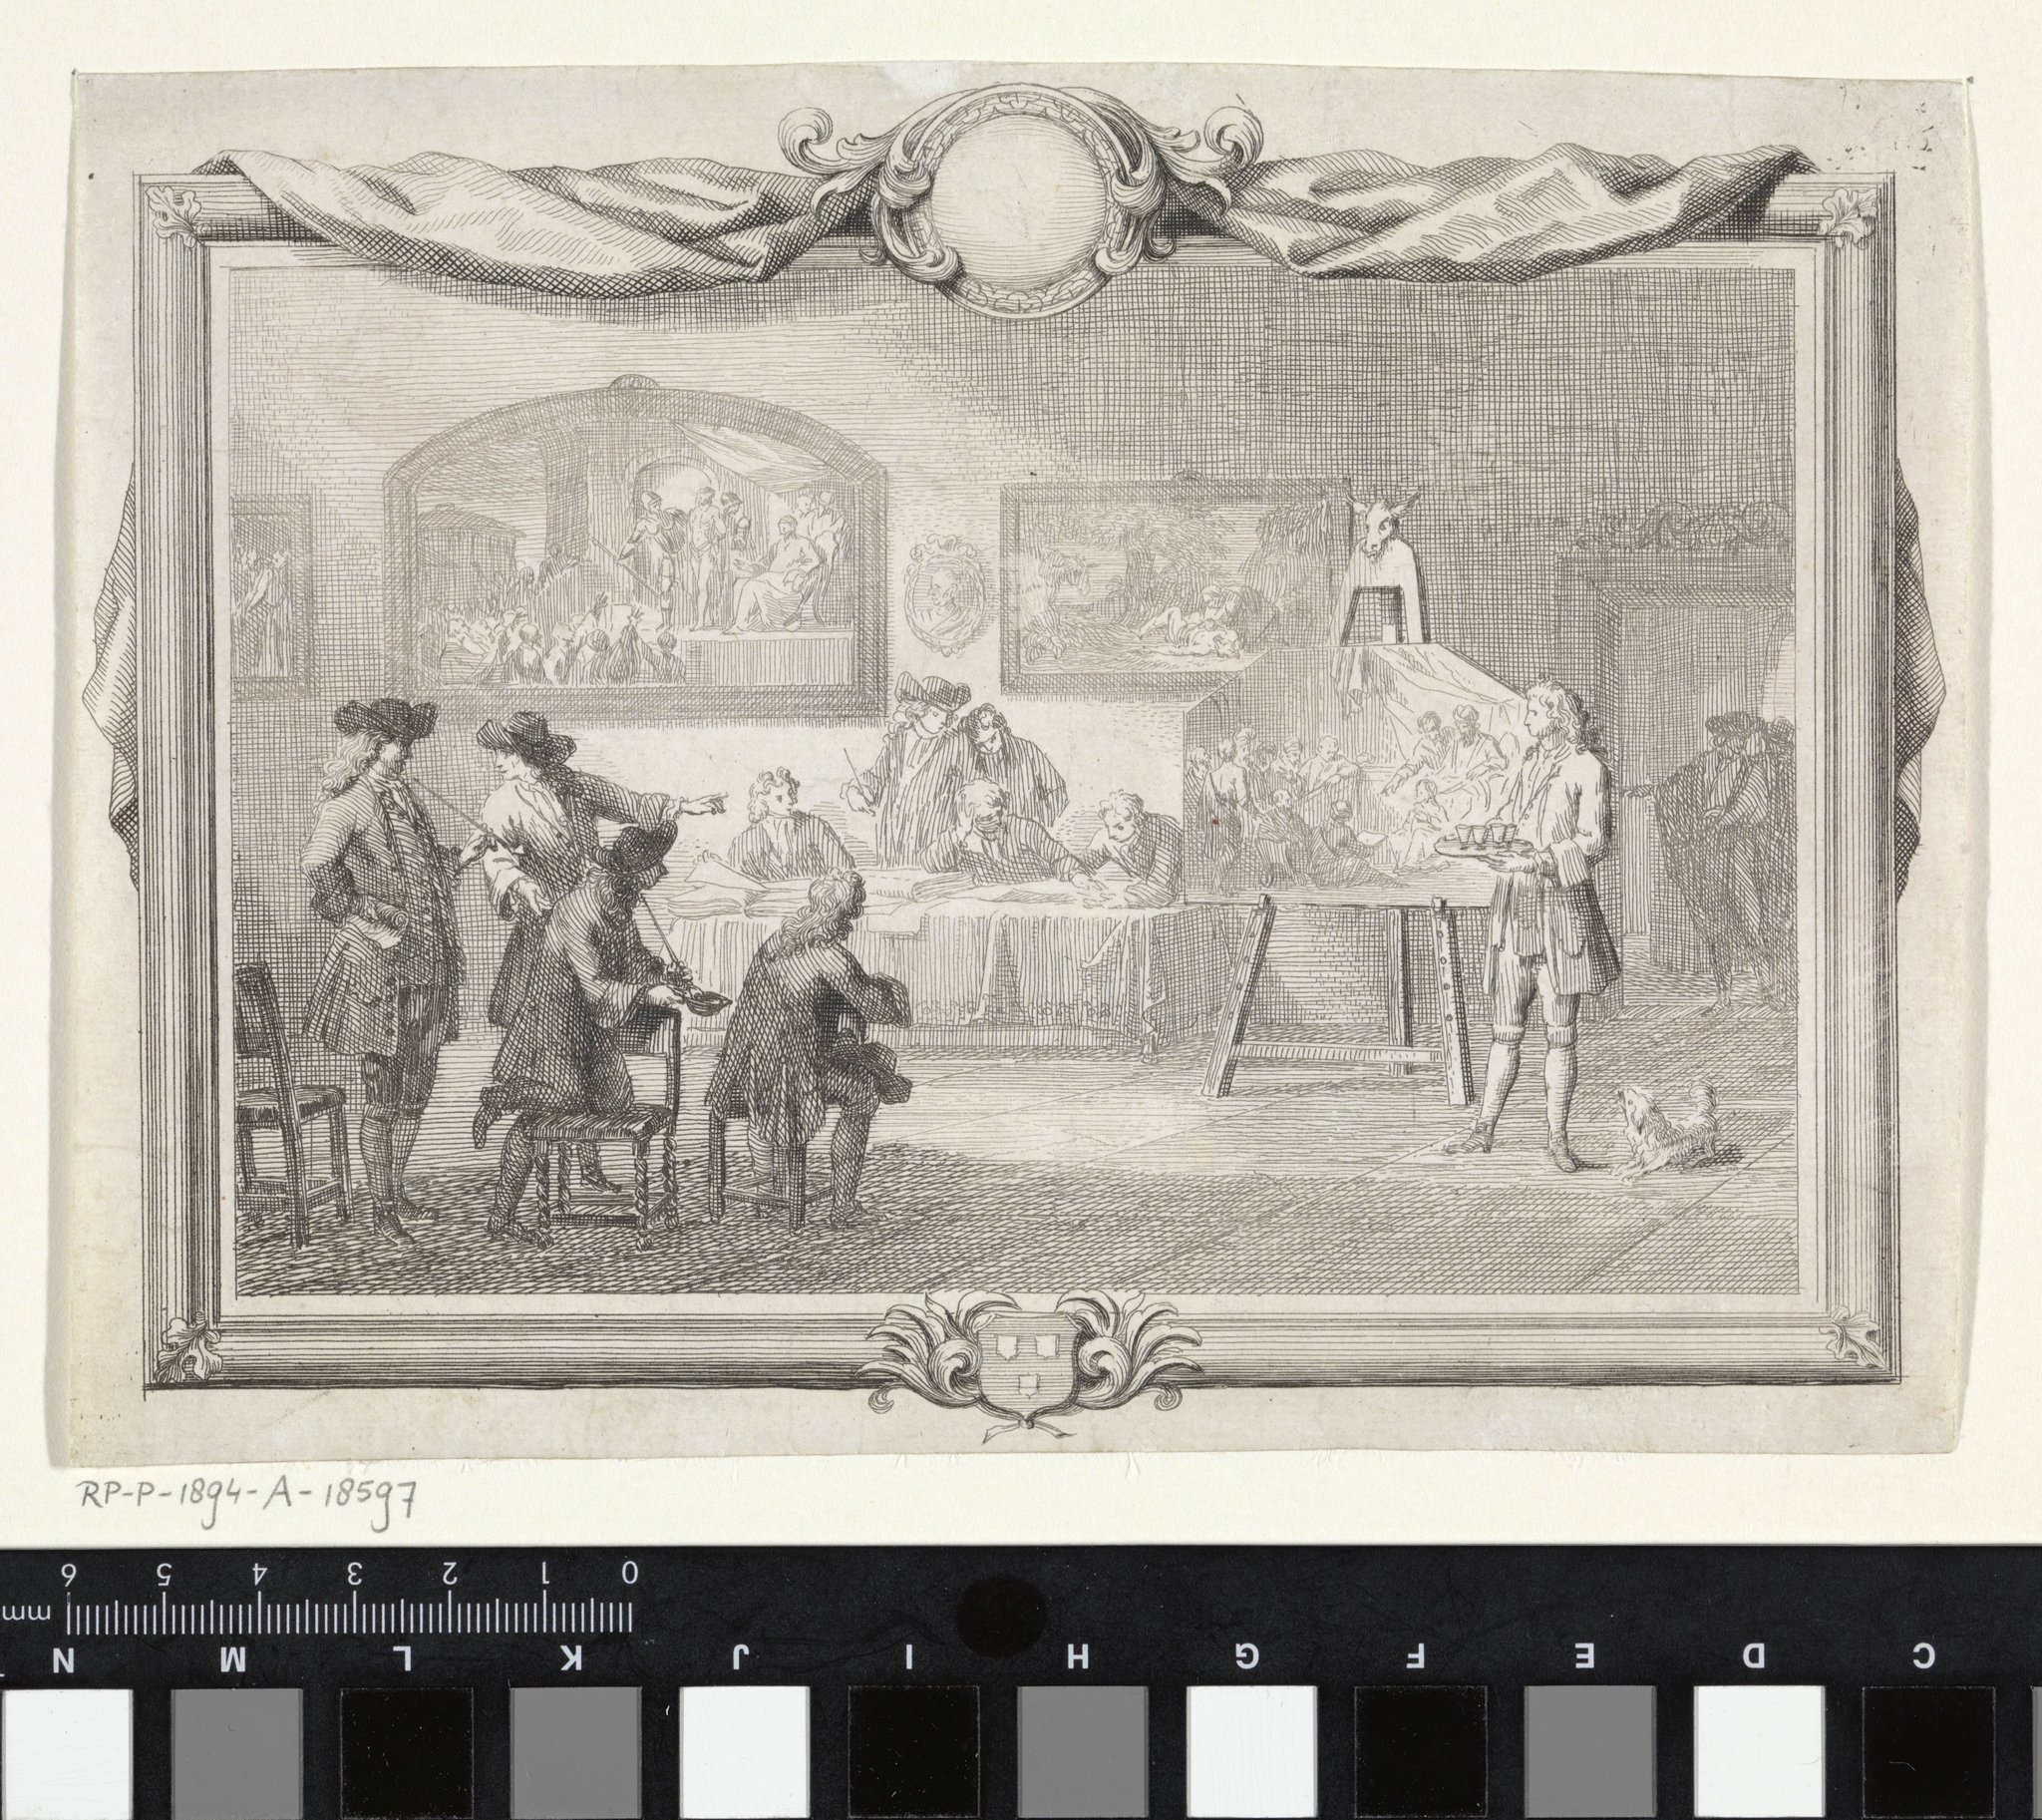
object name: print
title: Bijeenkomst van het broederschap St. Lukas te Dordrecht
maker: aert schouman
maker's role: draughtsman, painter, print maker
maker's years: 1710-1792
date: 1736-1792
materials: paper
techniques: etching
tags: criticizing and discussing art, art criticism (+ professional organization ~ arts), guild of st. luke, dordrecht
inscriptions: collector's mark: Lugt 2228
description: Kunstbeschouwing door leden van het in 1736 door Aert Schouman opgerichte broederschap van Sint Lukas, een vereniging van kunstliefhebbers en amateurs voor Dordrecht en omstreken. Aan een tafel buigt een aantal heren zich over boeken en papieren. Vier pijprokende heren kijken van een afstandje naar een schilderij op een ezel. Daarnaast staat een bediende met een dienblad met glazen. In een vierkante randlijst, waarover een draperie hangt. In het midden bovenaan een ronde -opengelaten- cartouche, onderaan het wapen van het St. Lukasgilde.